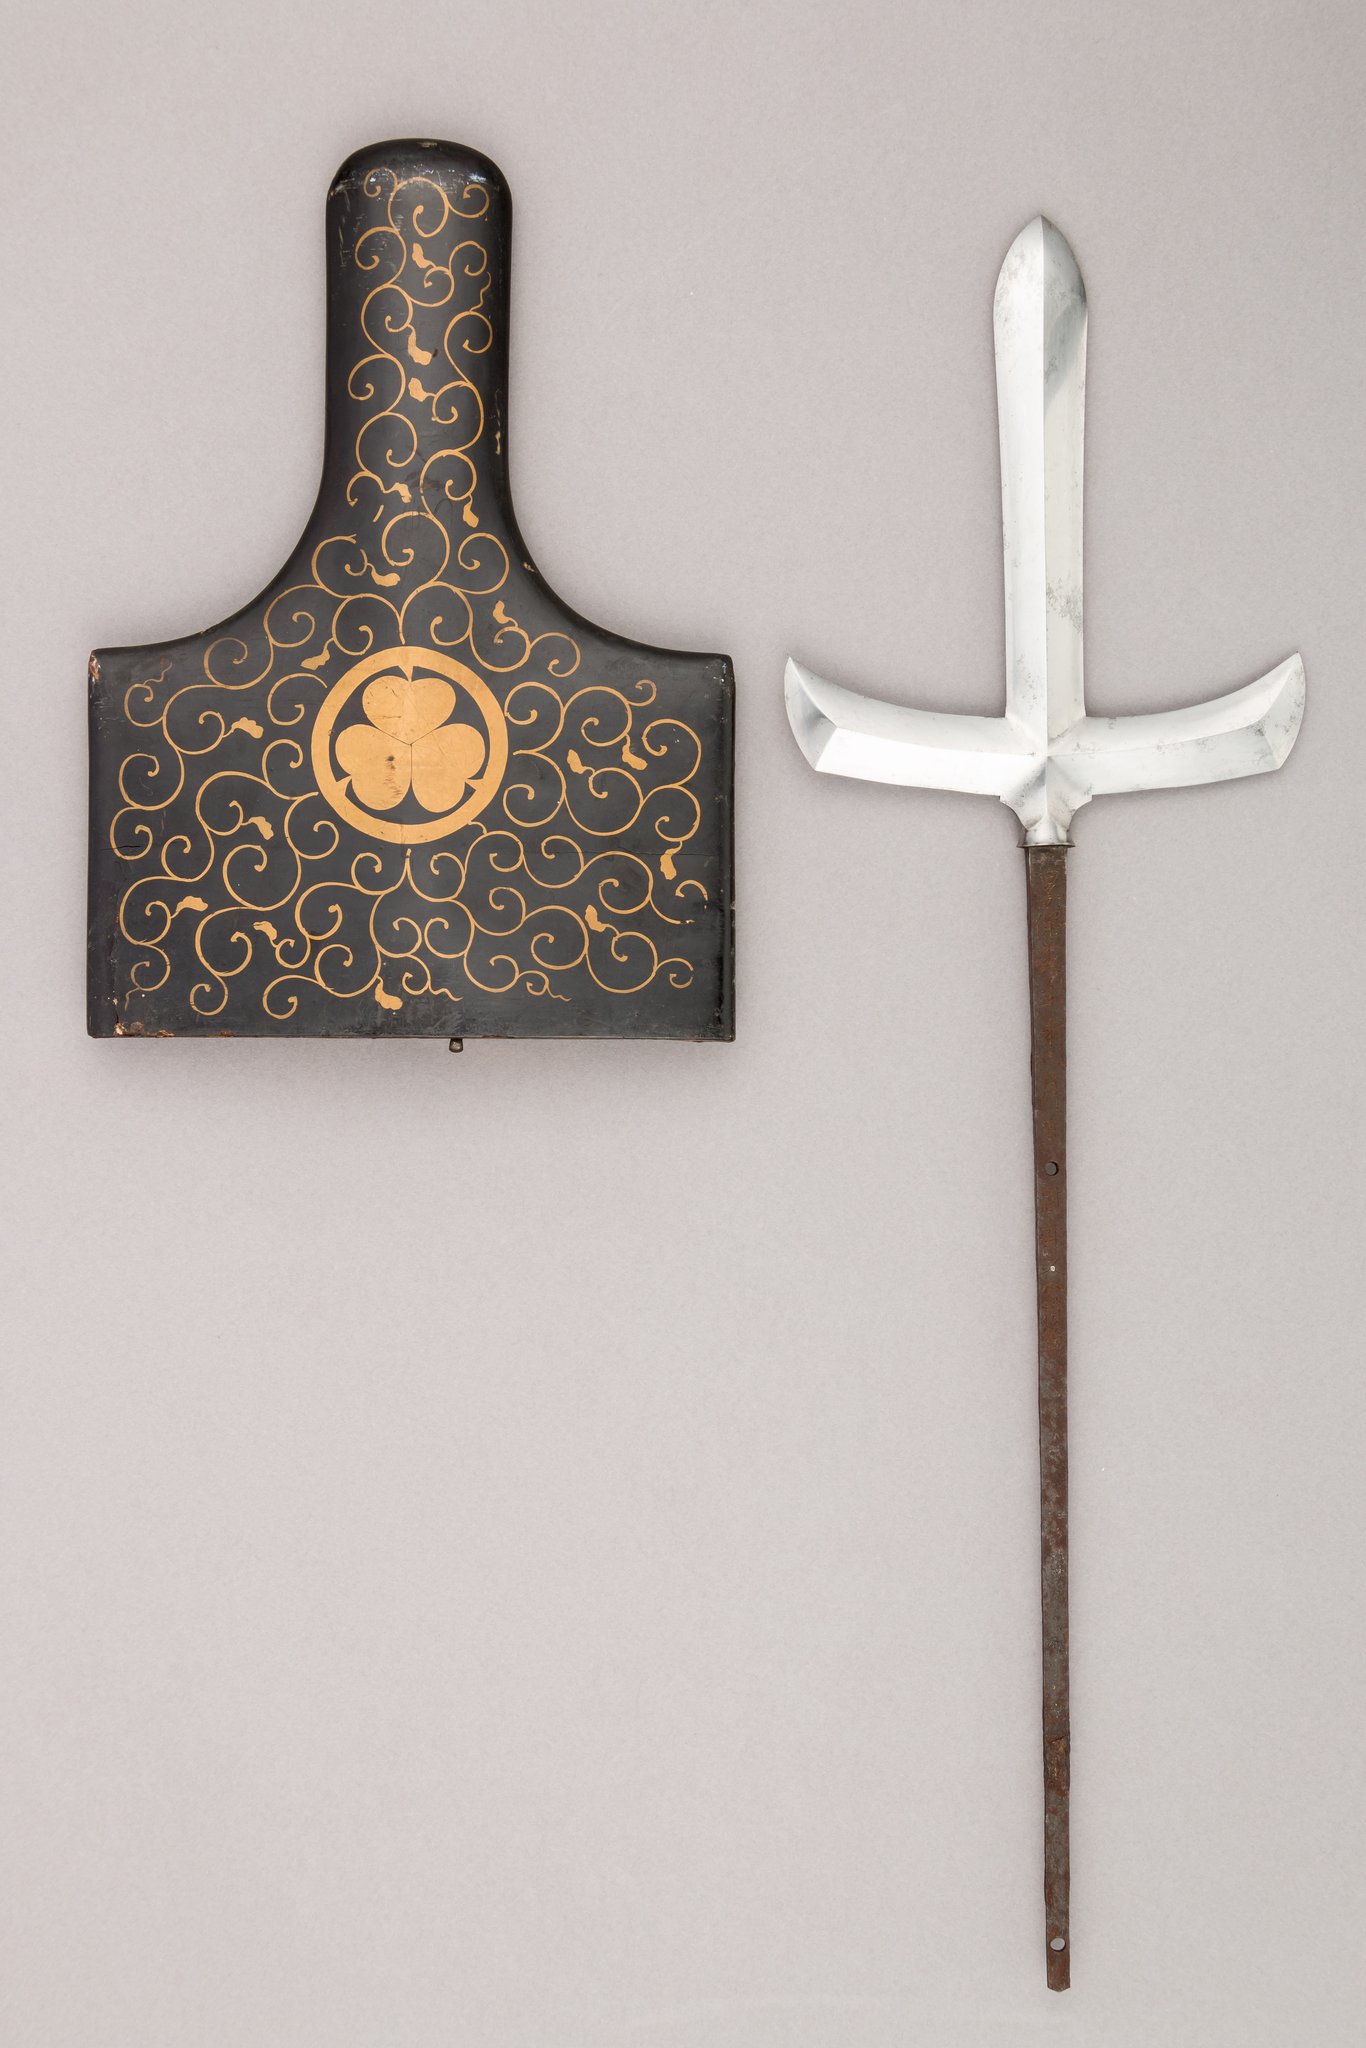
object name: blade for a spear i jumonji yari i with sheath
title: Blade for a Spear (Jūmonji-yari) with Sheath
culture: japanese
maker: munemichi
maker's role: bladesmith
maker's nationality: japanese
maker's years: 1701-1800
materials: copper, gold, lacquer, steel, wood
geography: japan